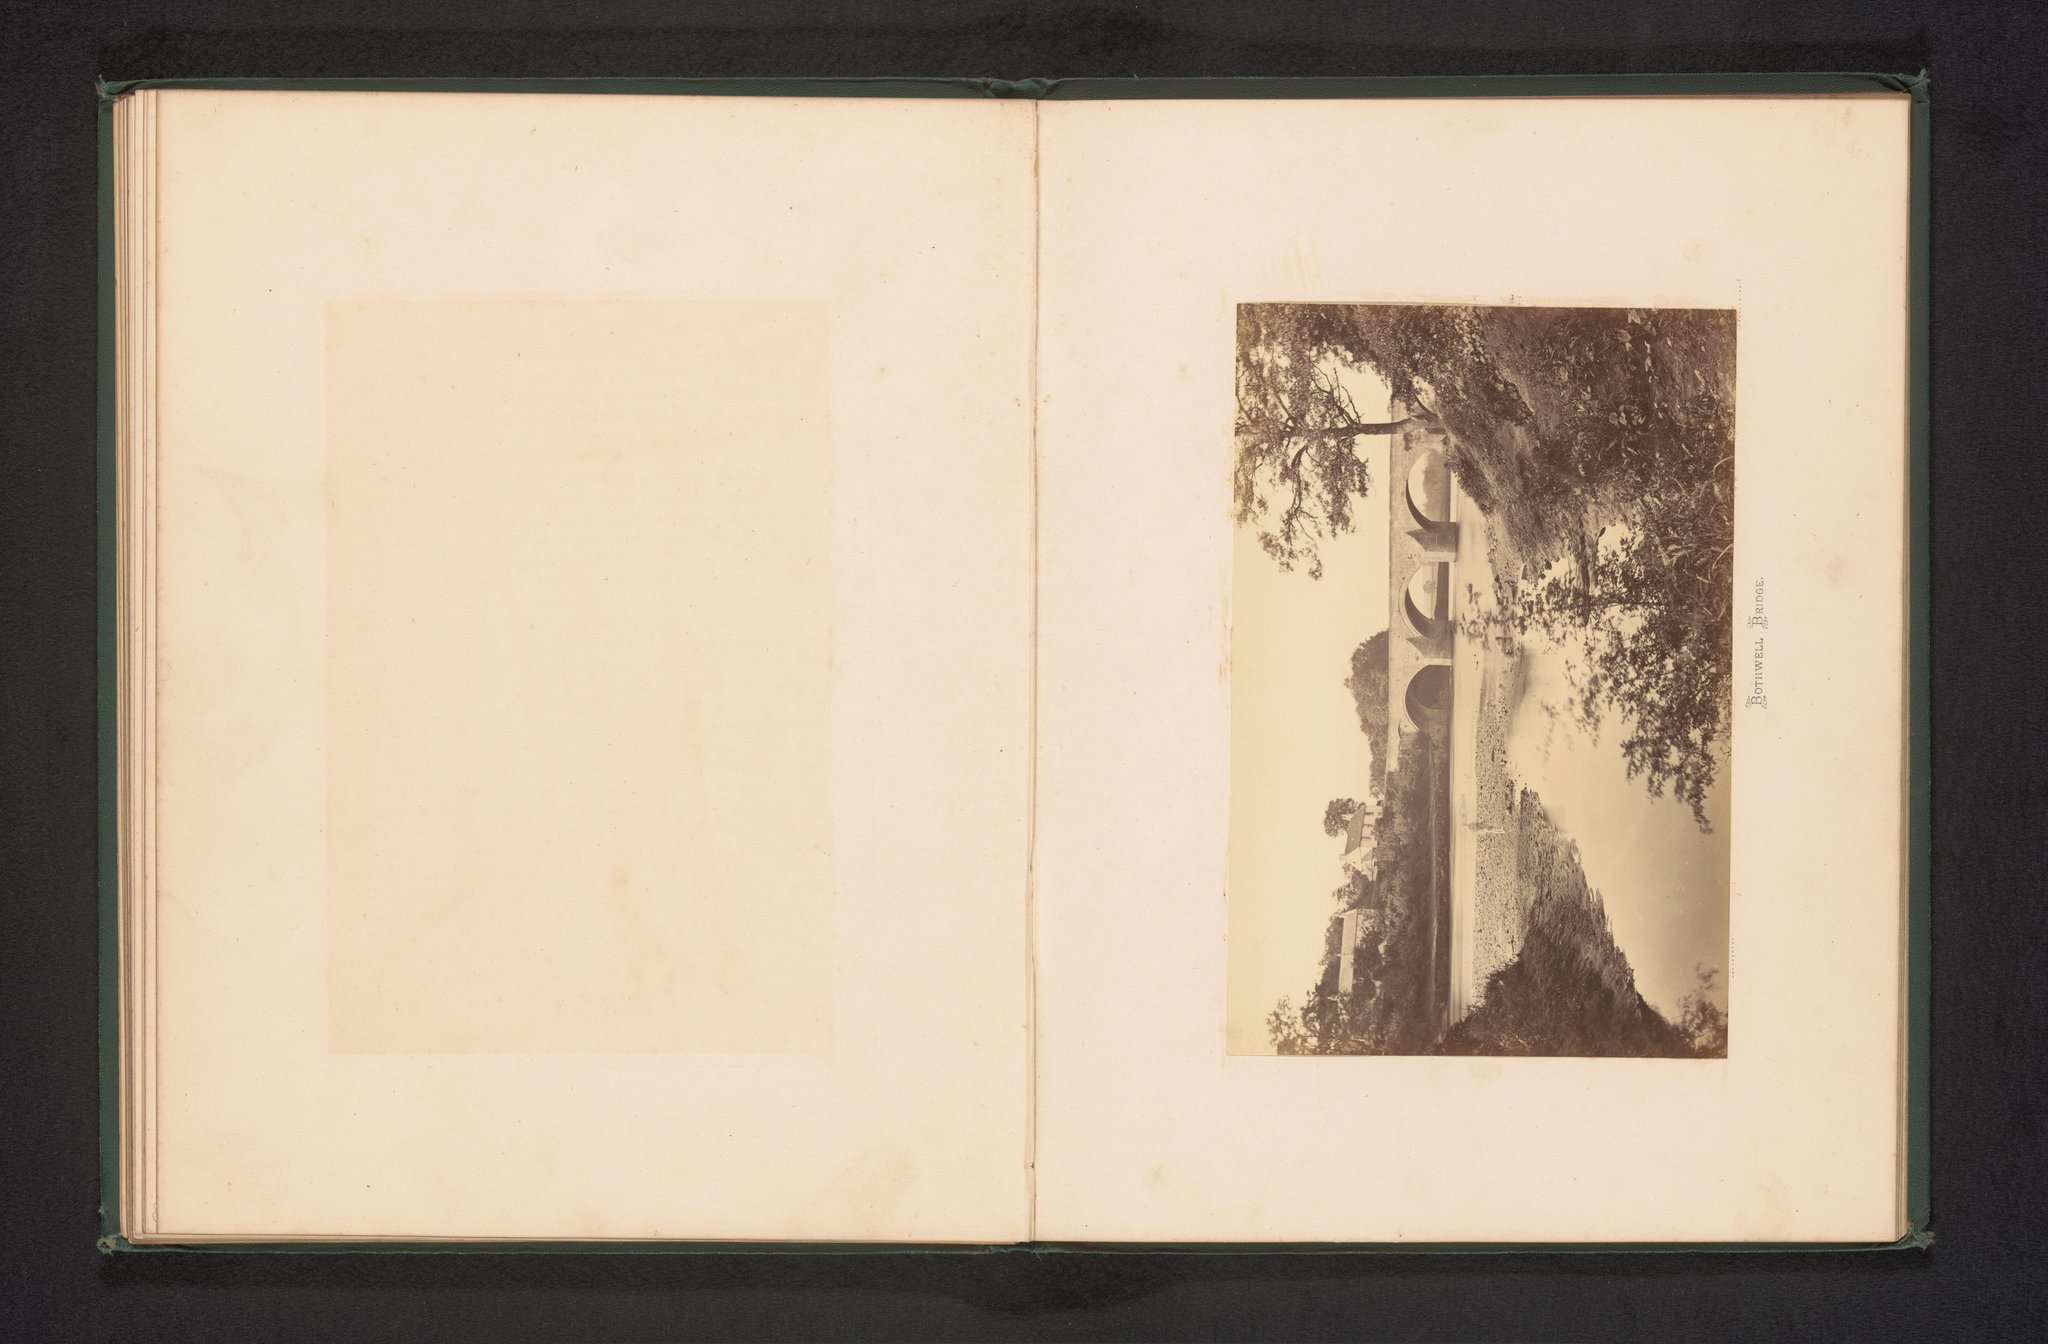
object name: page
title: Bothwell Bridge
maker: Anonymous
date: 1862-1867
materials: photographic support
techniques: albumen print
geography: south lanarkshire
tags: river, landscapes with waters, waterscapes, seascapes (in the temperate zone), bridge